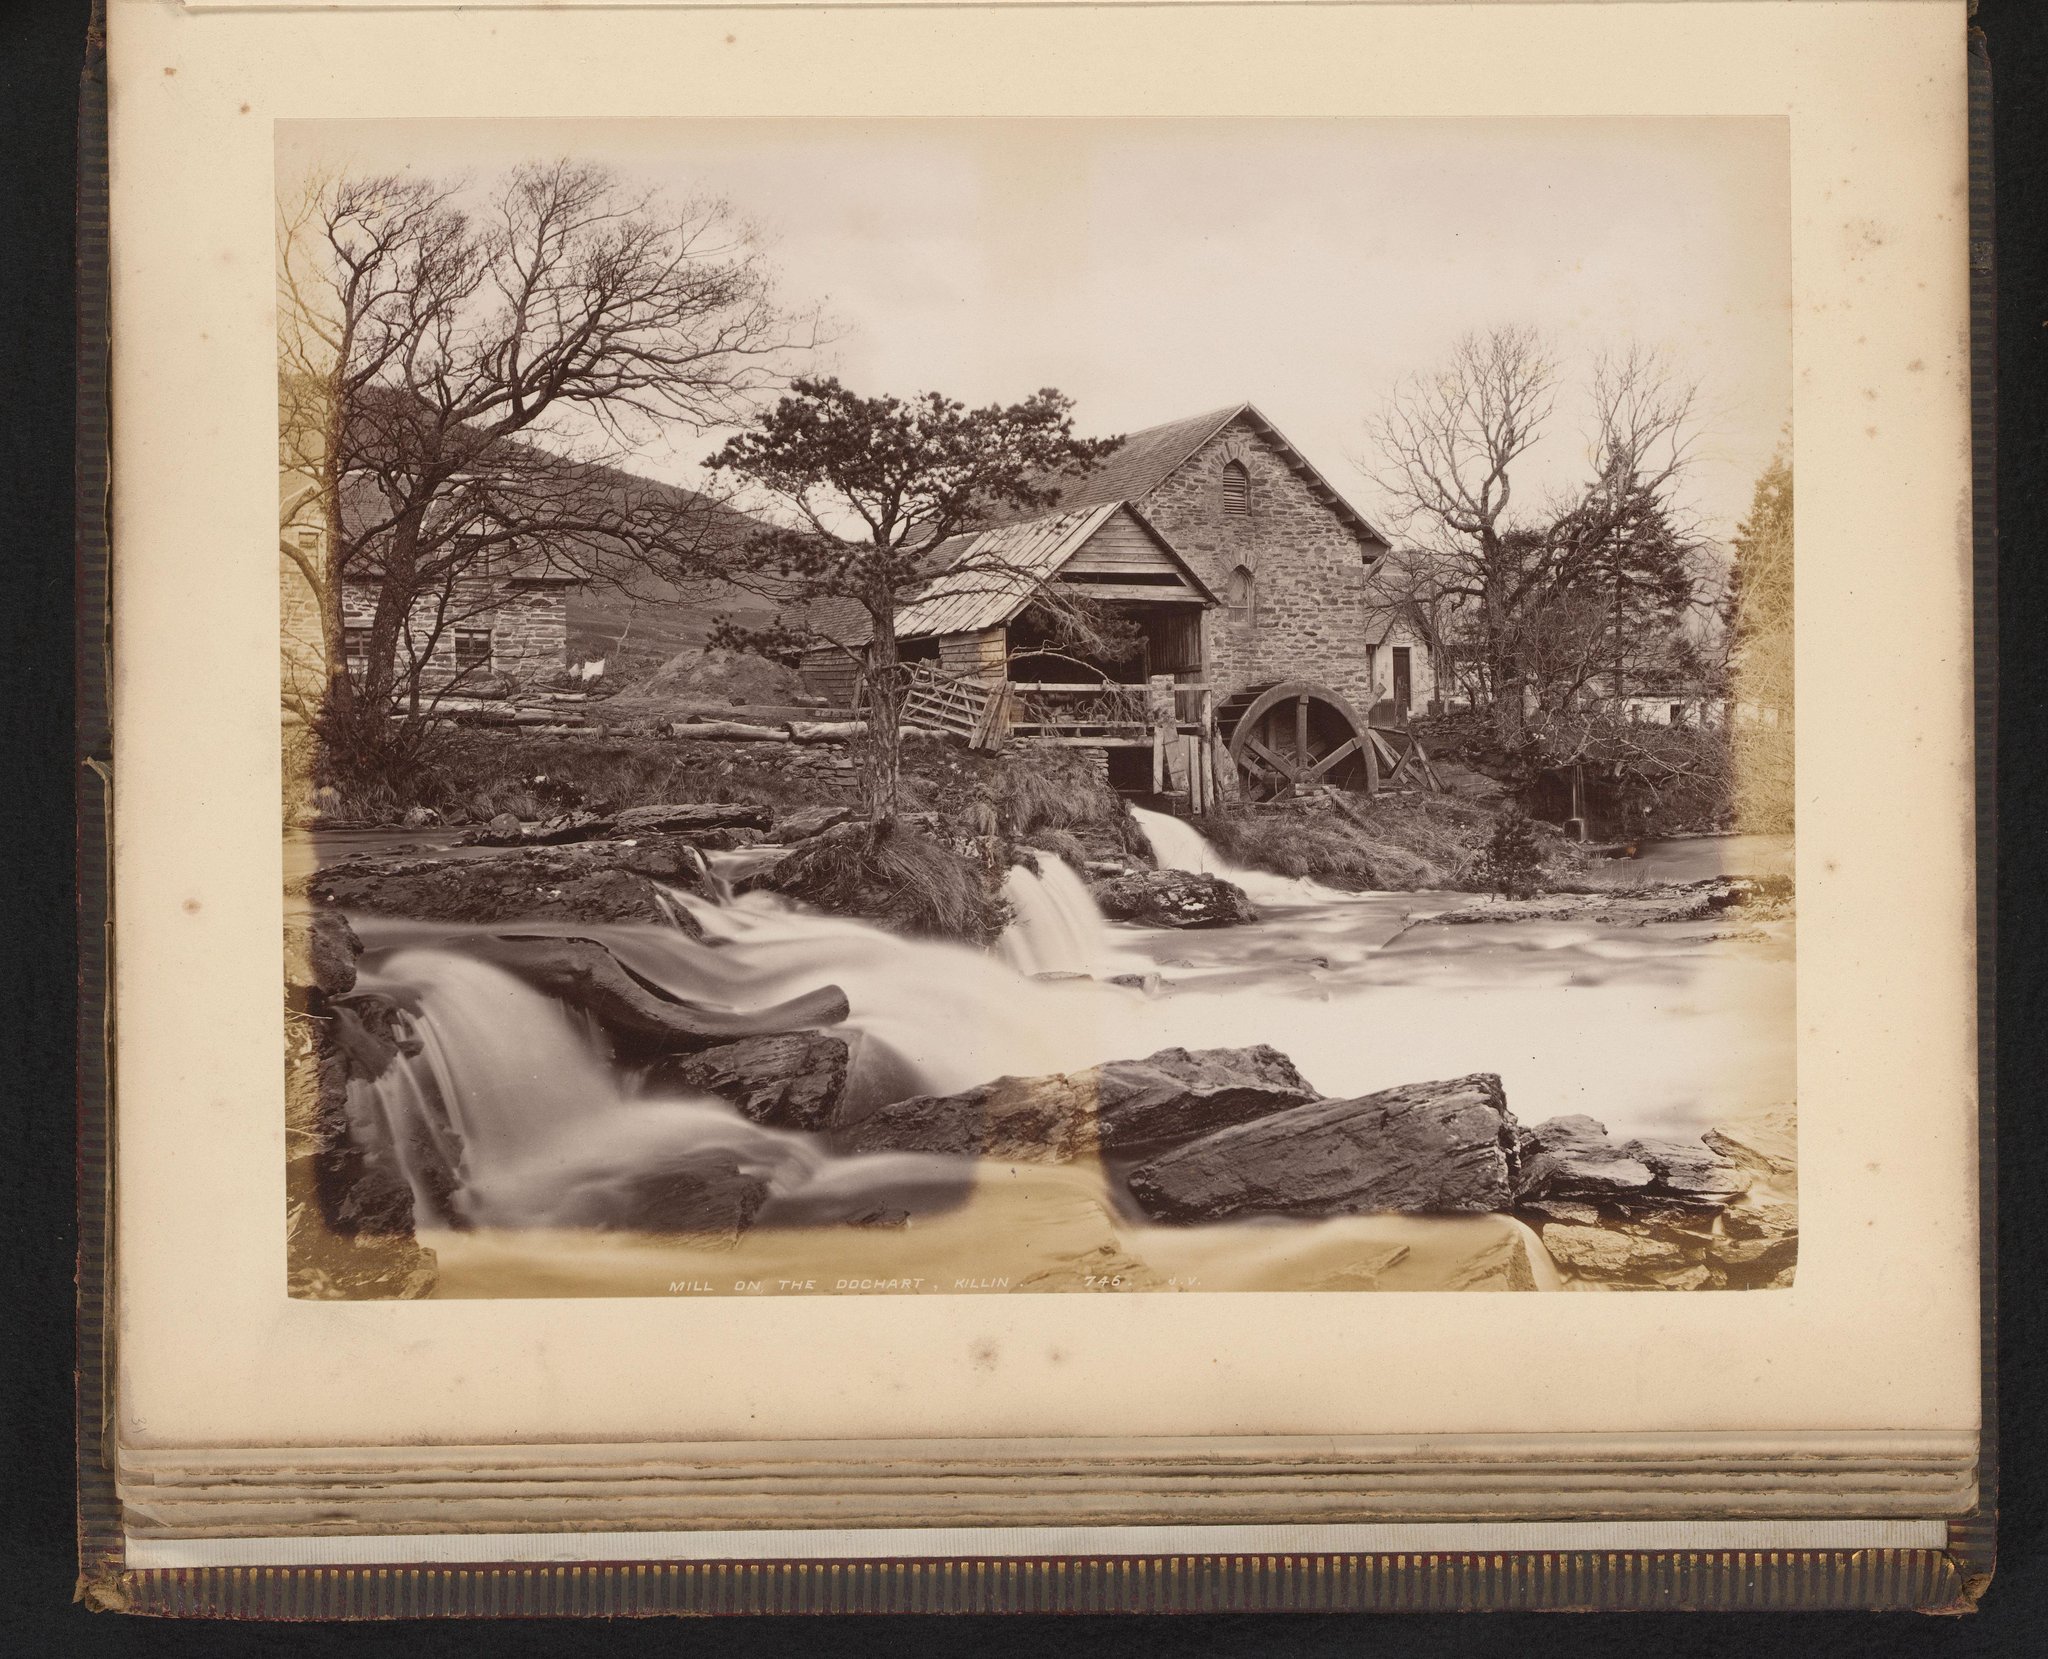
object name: album leaf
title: Mill on the Docharts, Killin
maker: Anonymous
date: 1875-1885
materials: photographic support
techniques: albumen print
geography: killin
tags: watermill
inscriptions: number: ‘746, J.V.’